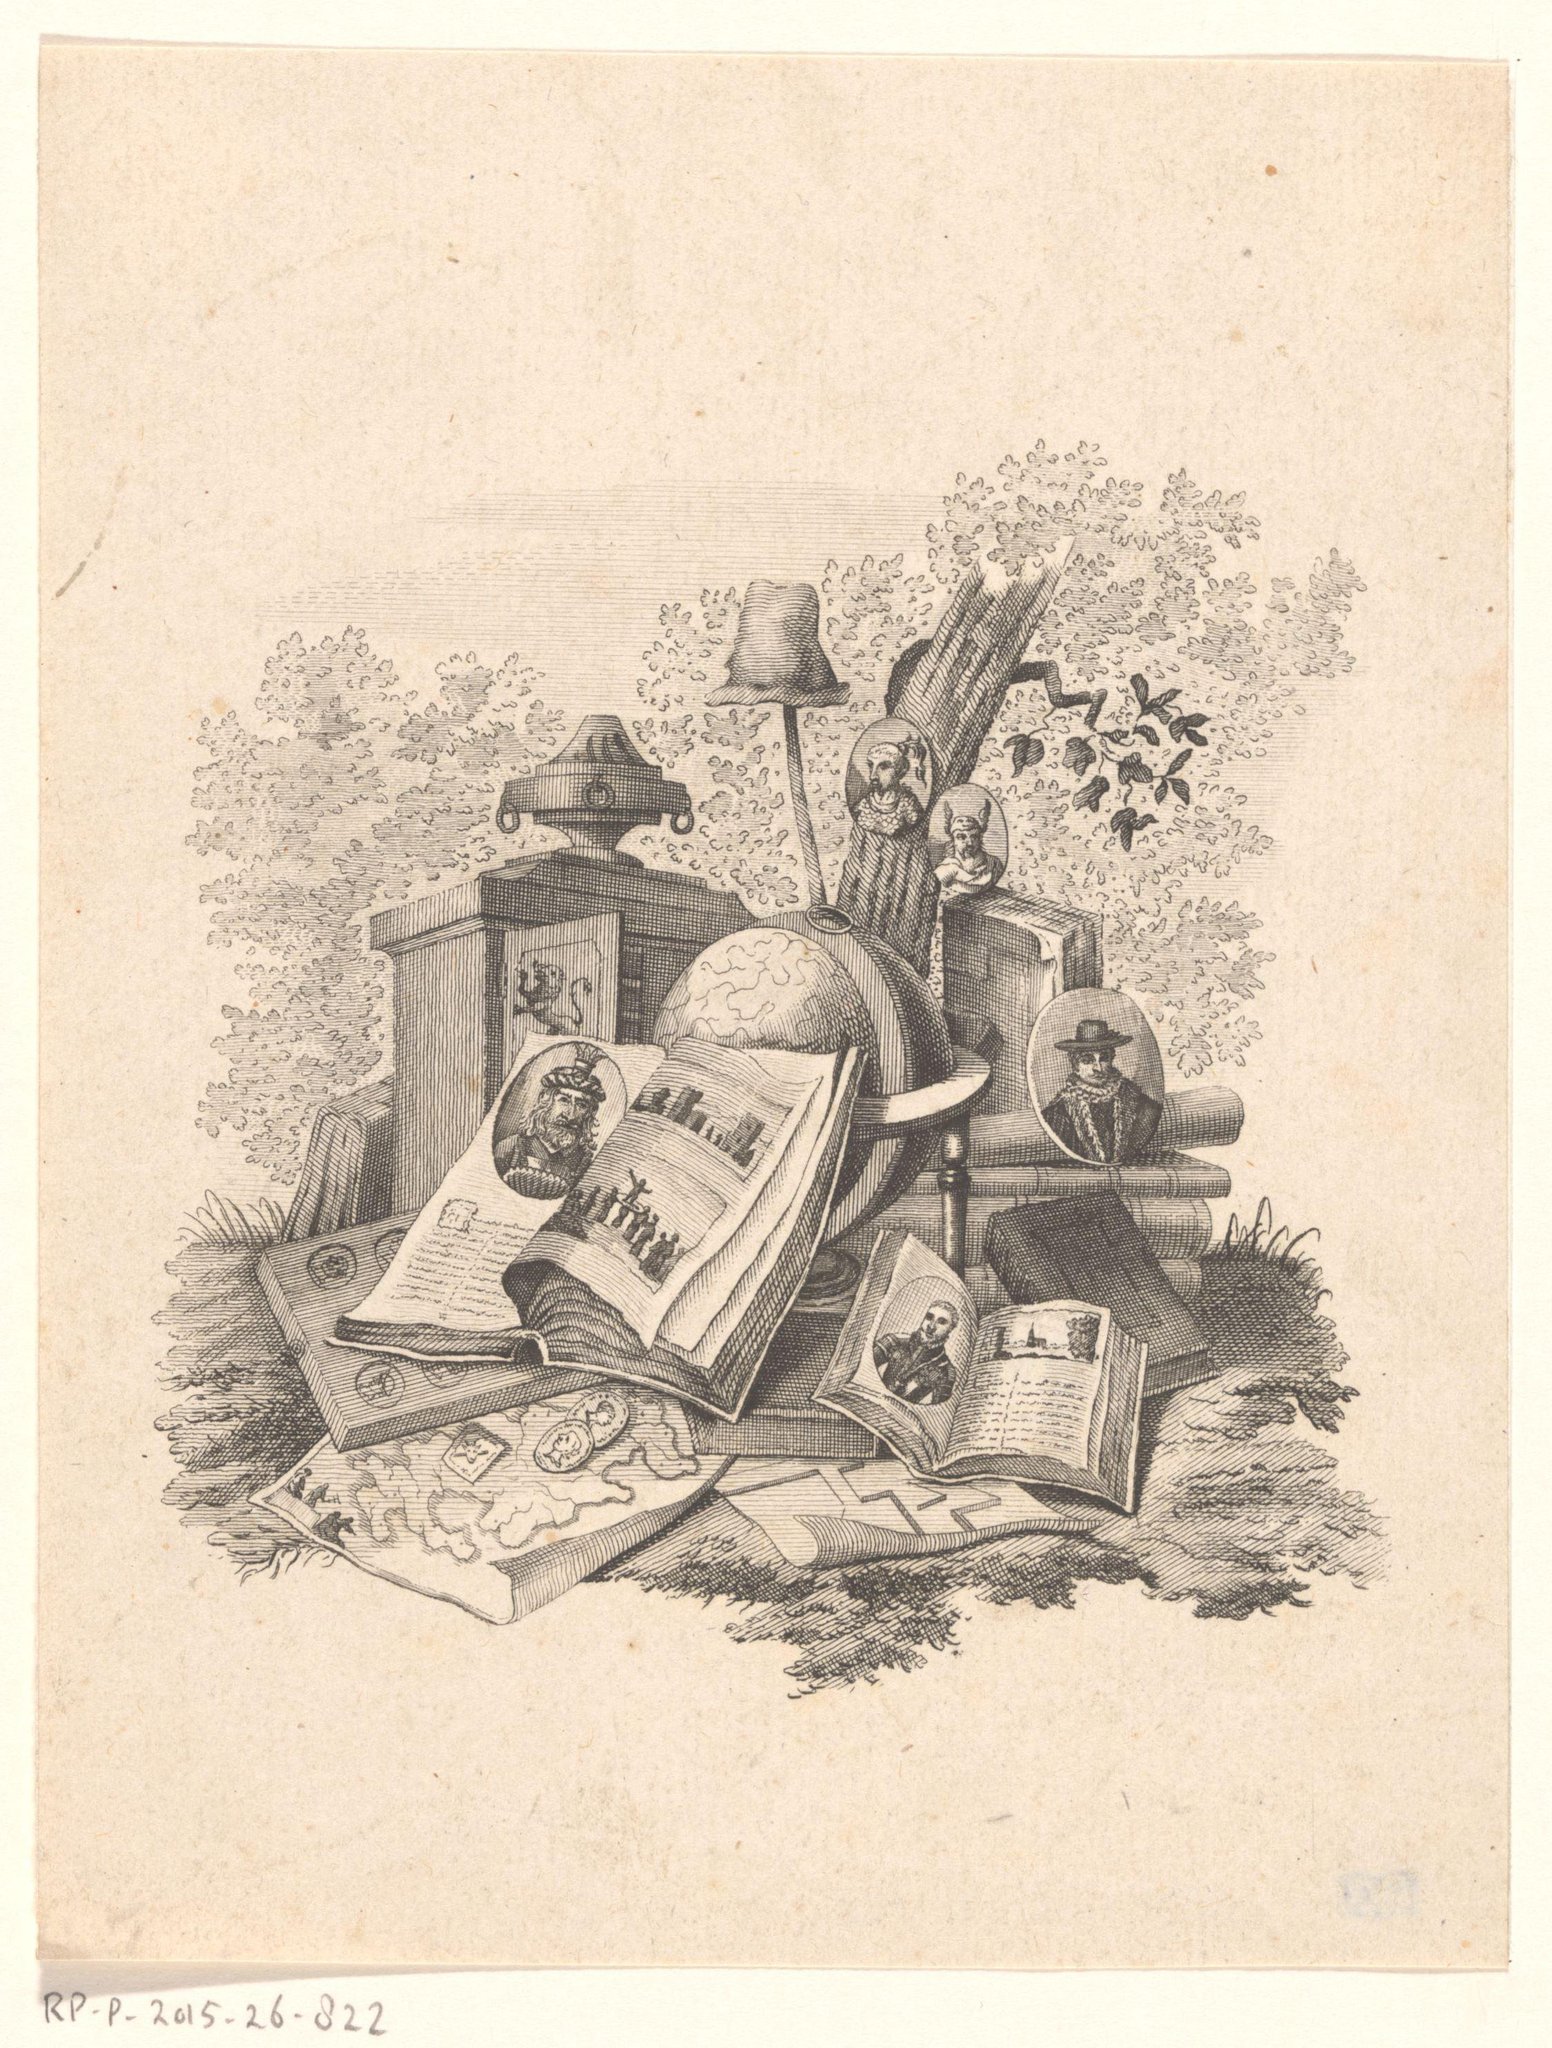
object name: print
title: Stilleven in de buitenlucht met een globe, boeken en portretten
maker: Anonymous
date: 1700-1799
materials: paper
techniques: etching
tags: still life of related objects, book in which illustrations are essential - mm - book open, globe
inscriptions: collector's mark: Lugt 4780, collector's mark: Lugt 2228, collector's mark: Lugt 4779